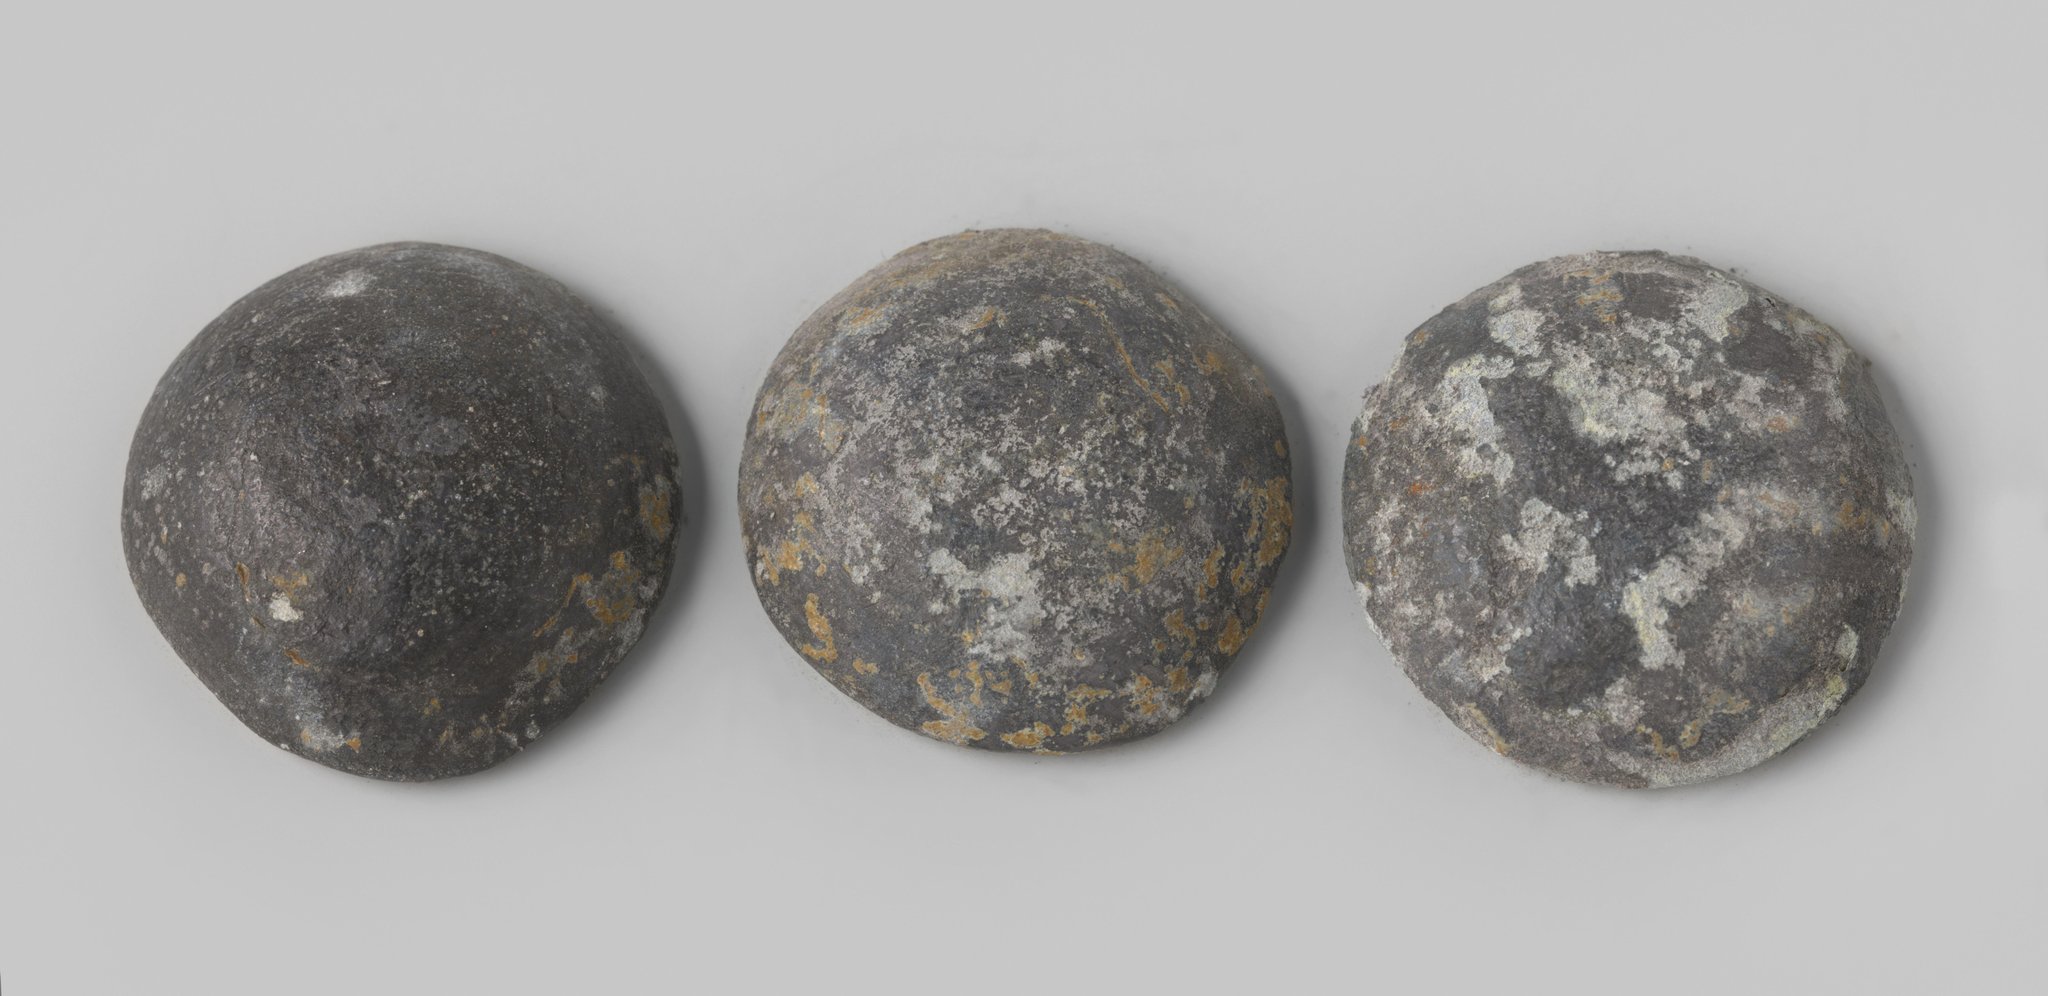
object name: weight scale component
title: Gewichten uit het wrak van de Oost-Indiëvaarder Hollandia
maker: Anonymous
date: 1700-1743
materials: lead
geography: netherlands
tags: verenigde oostindische compagnie, hollandia (schip), annet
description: Disc-shaped weight, circular, flat underside, domed top.